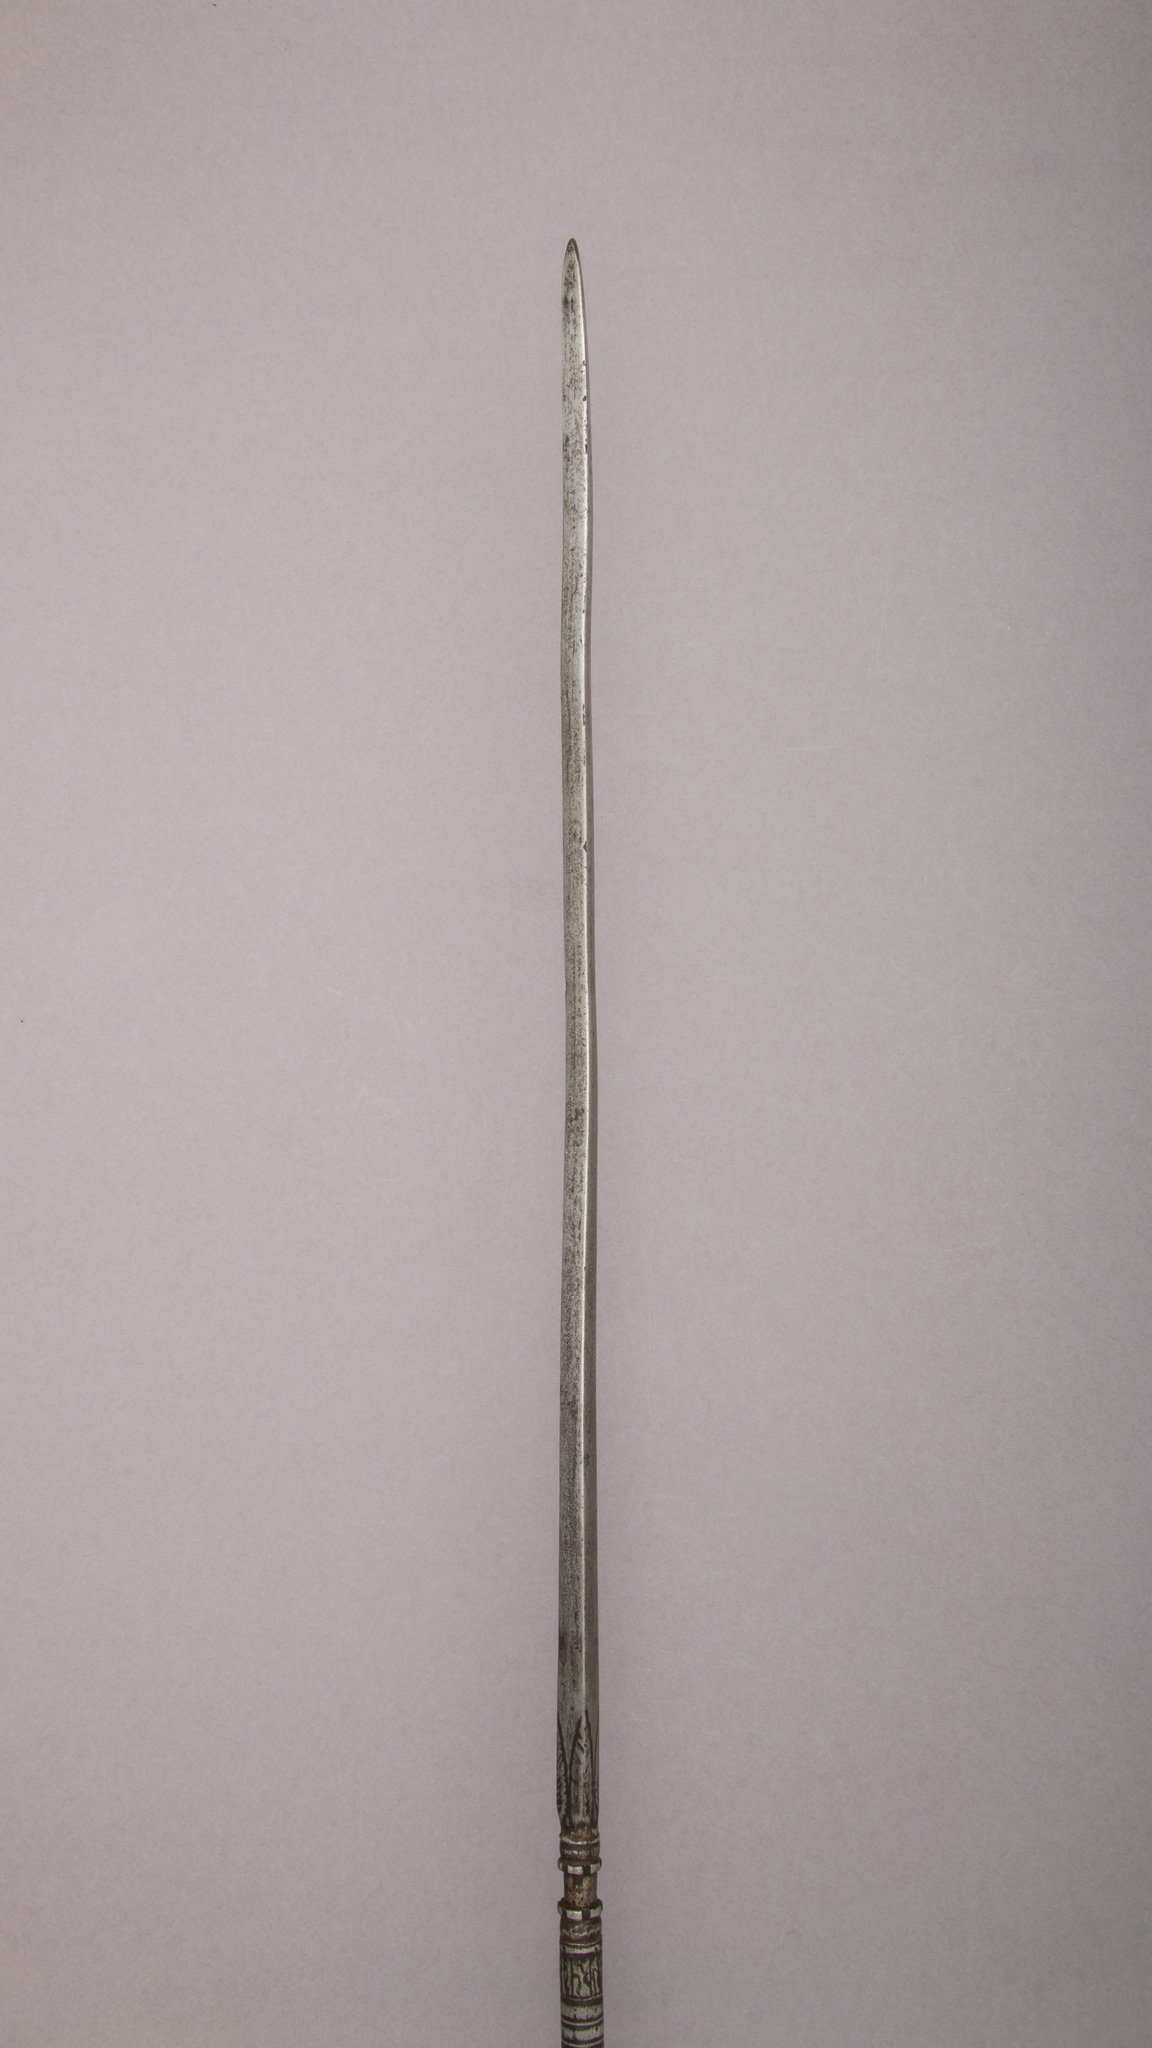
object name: spear sangu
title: Spear (Sangu)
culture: indian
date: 1701-1900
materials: steel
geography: india